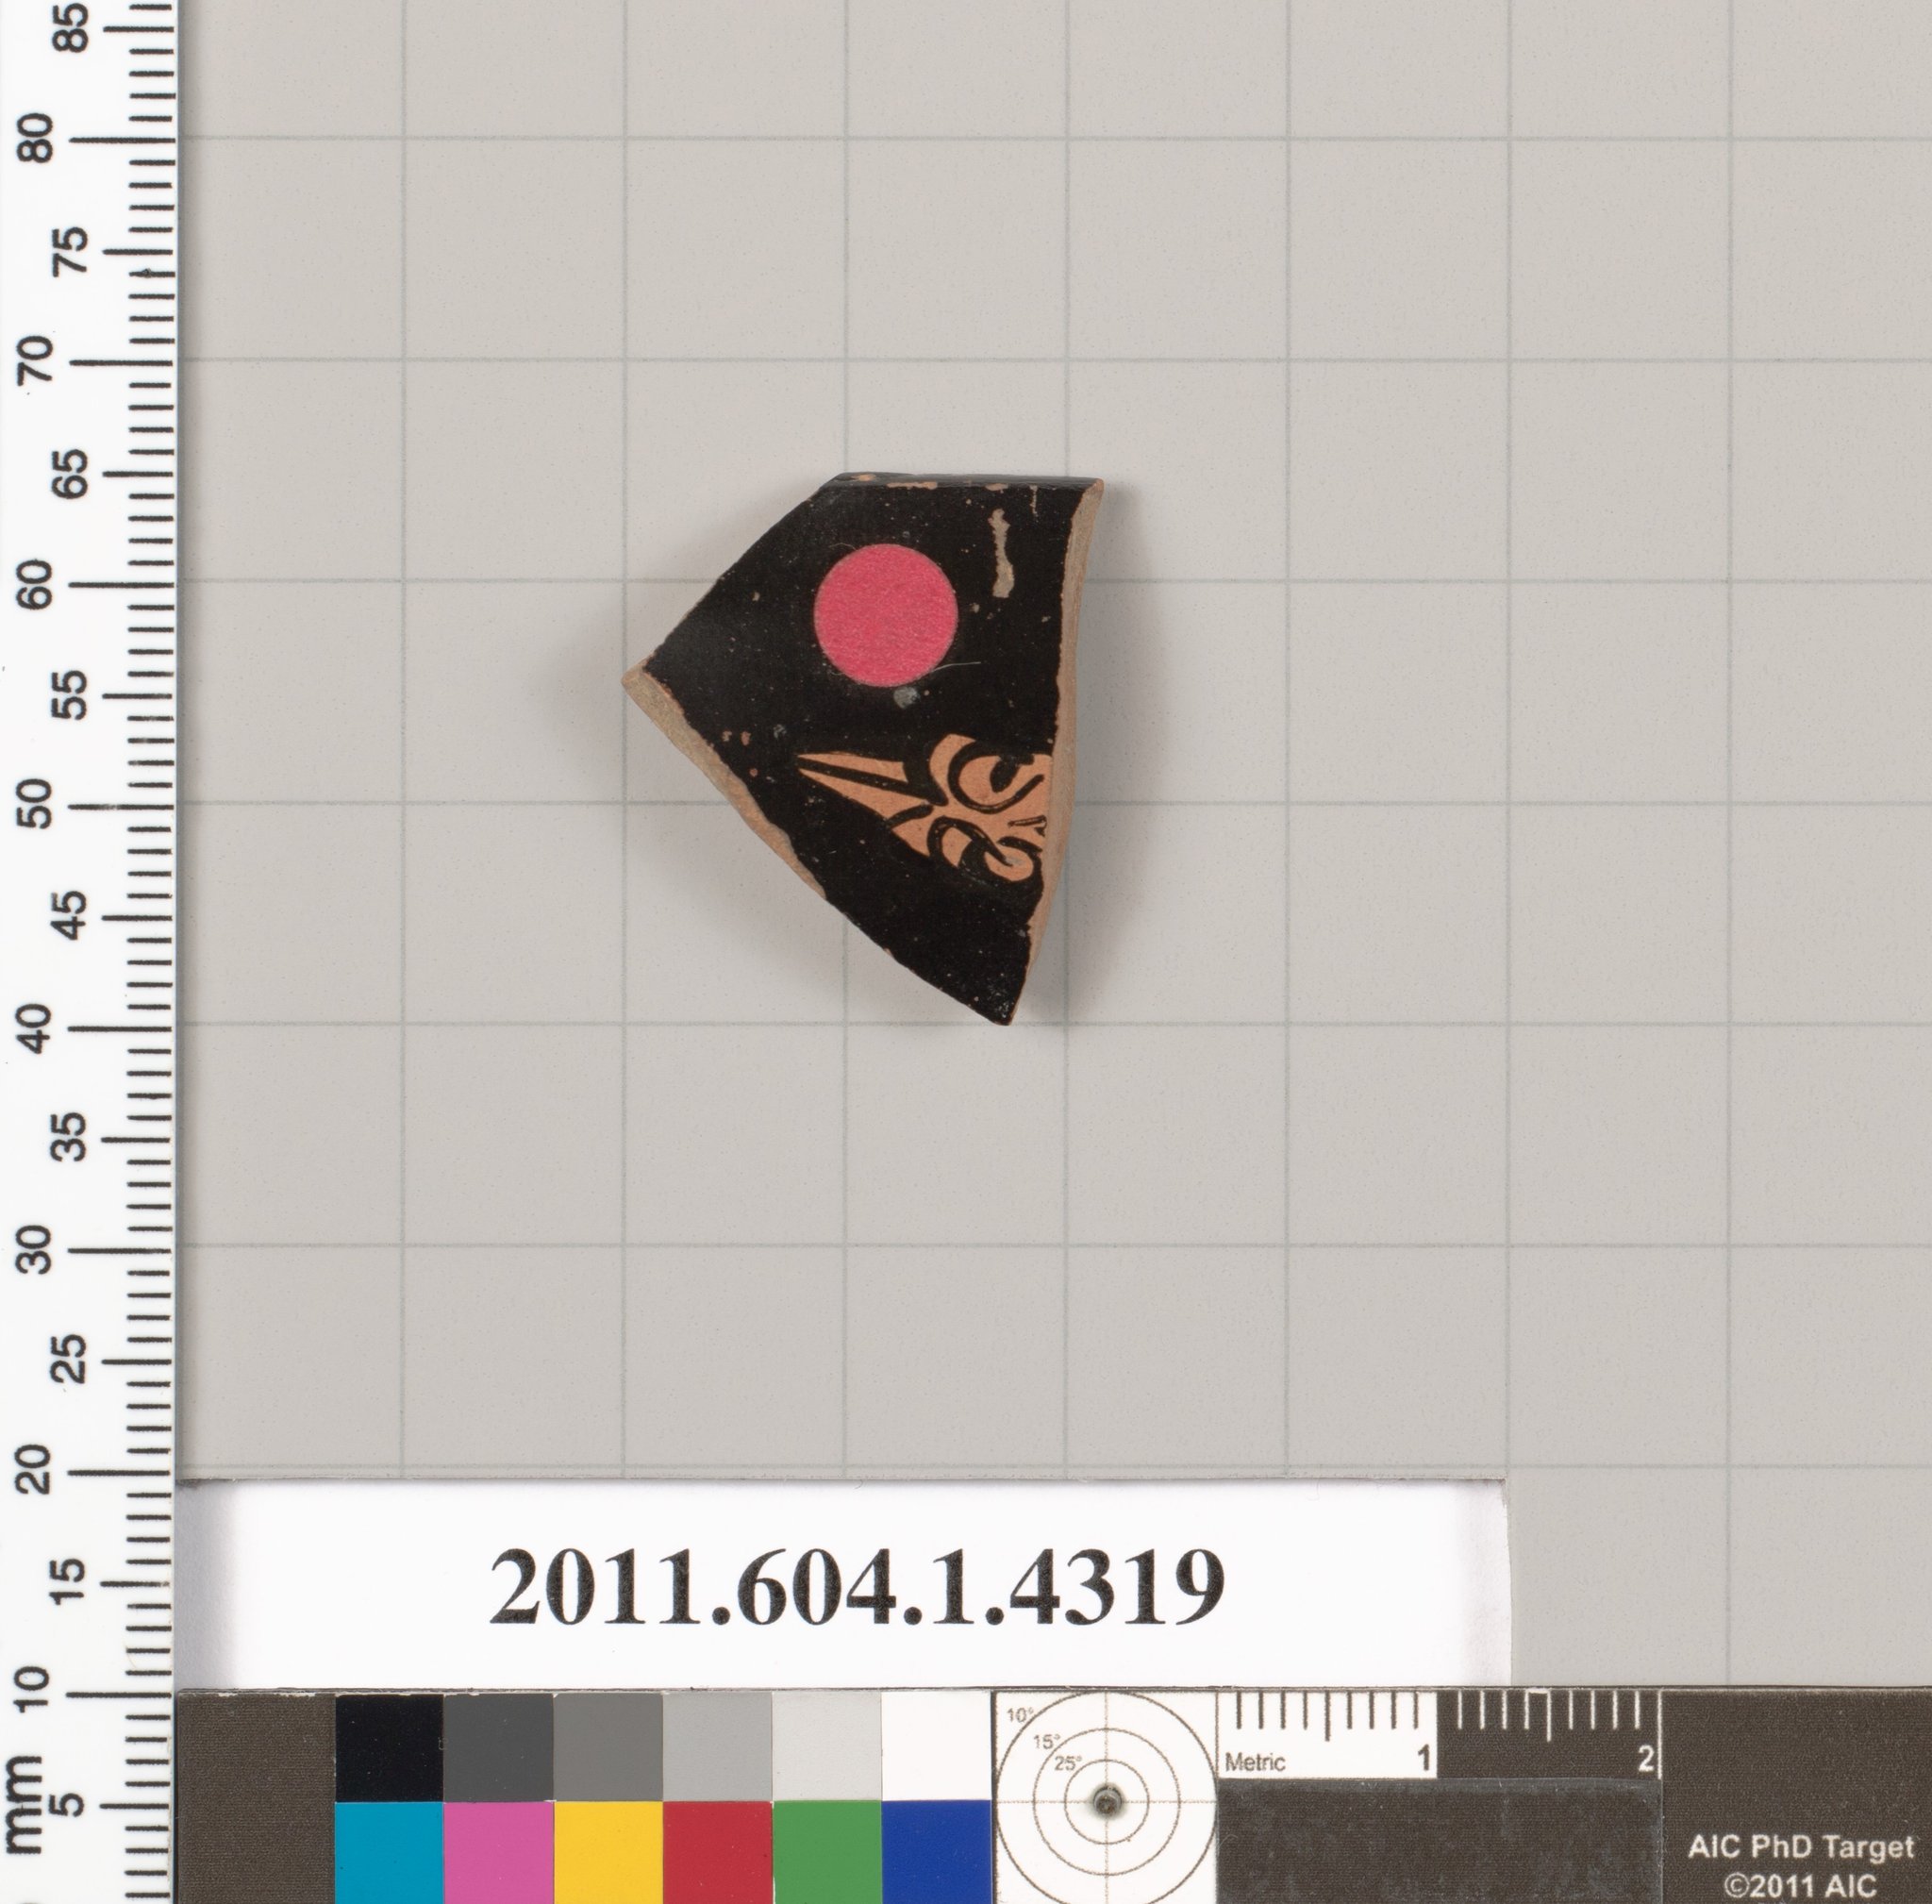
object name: kylix fragment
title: Terracotta rim fragment of a kylix (drinking cup)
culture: greek, attic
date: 500-451 BCE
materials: terracotta